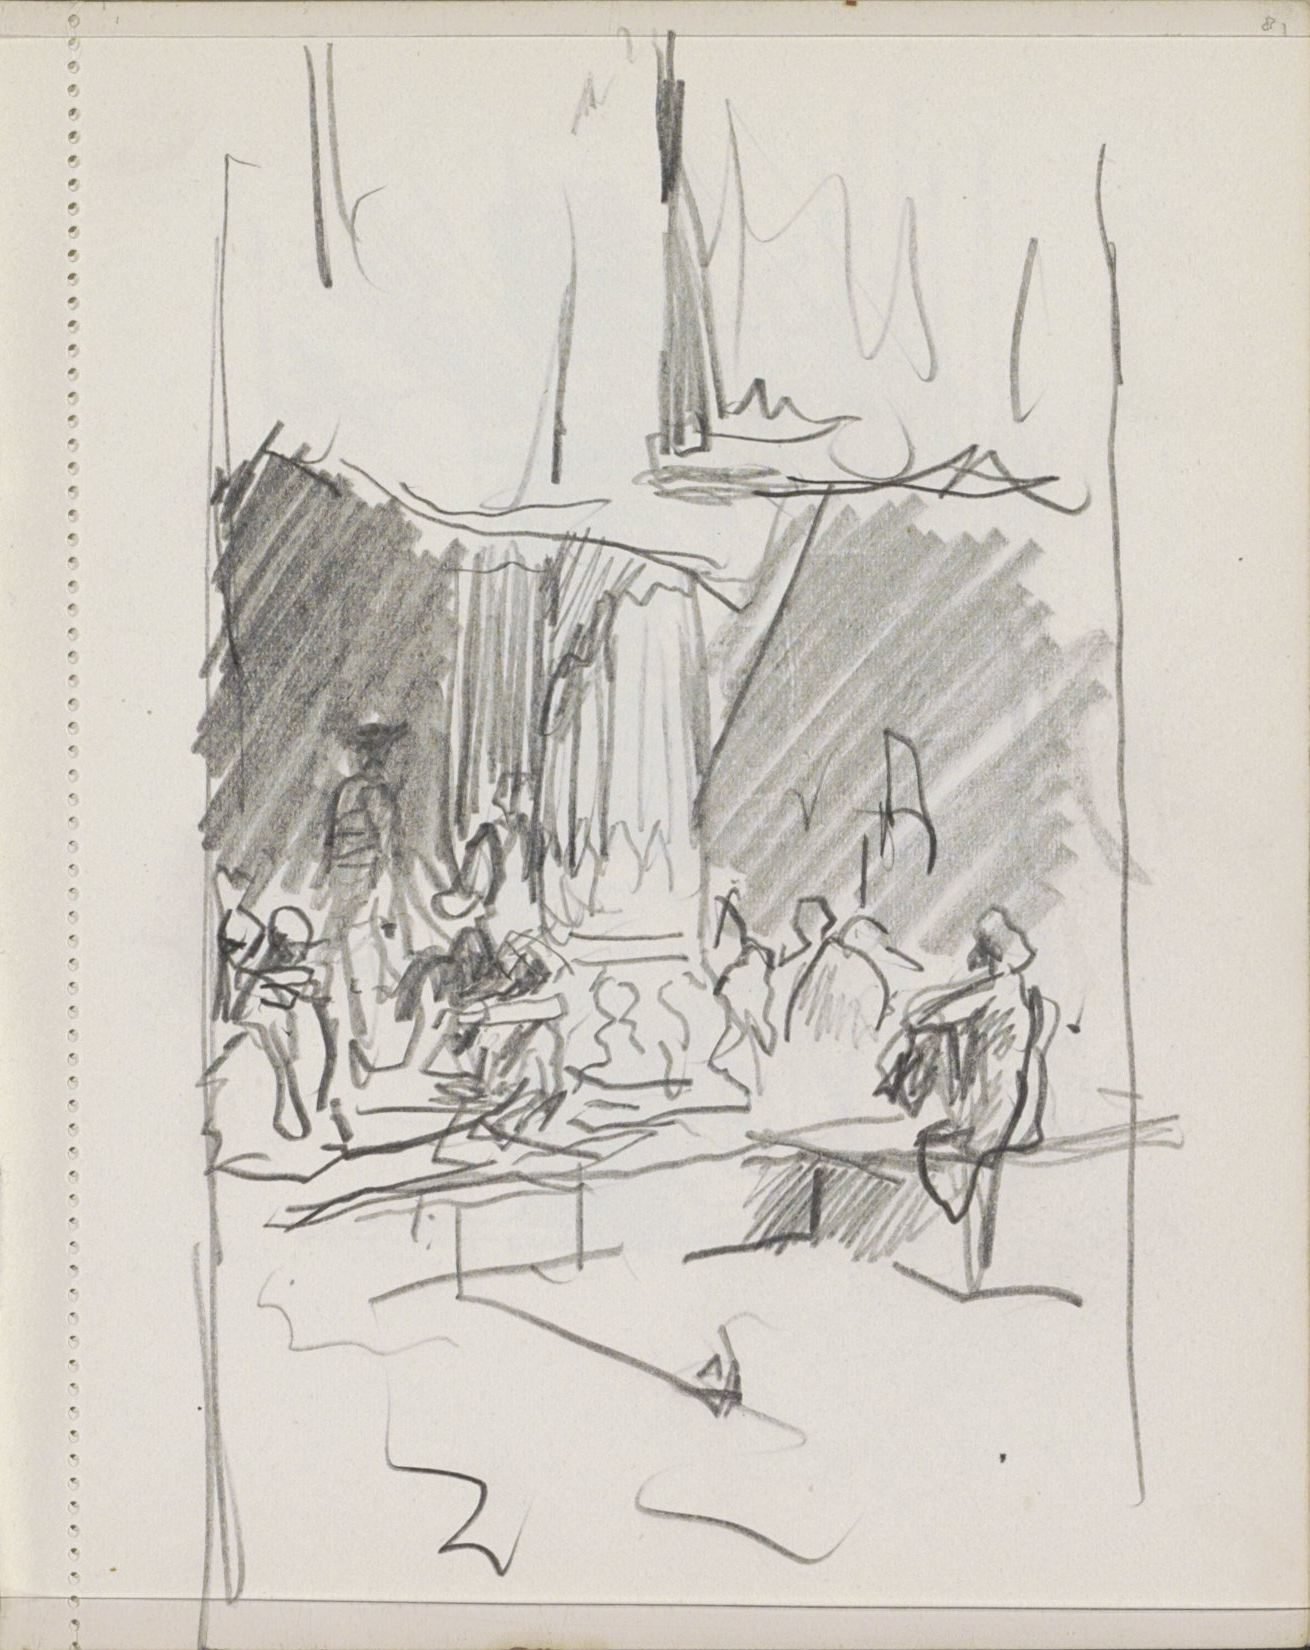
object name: sketchbook leaf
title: Figuren zittend bij een zuil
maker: marius bauer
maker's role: draughtsman, print maker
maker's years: 1867-1932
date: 1924-1925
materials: paper, pencil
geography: india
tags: sitting figure, column, pillar ~ architecture, asiatic races and peoples: indians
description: Mogelijk het interieur van een tempel. Pagina 81 uit een schetsboek met 75 bladen.